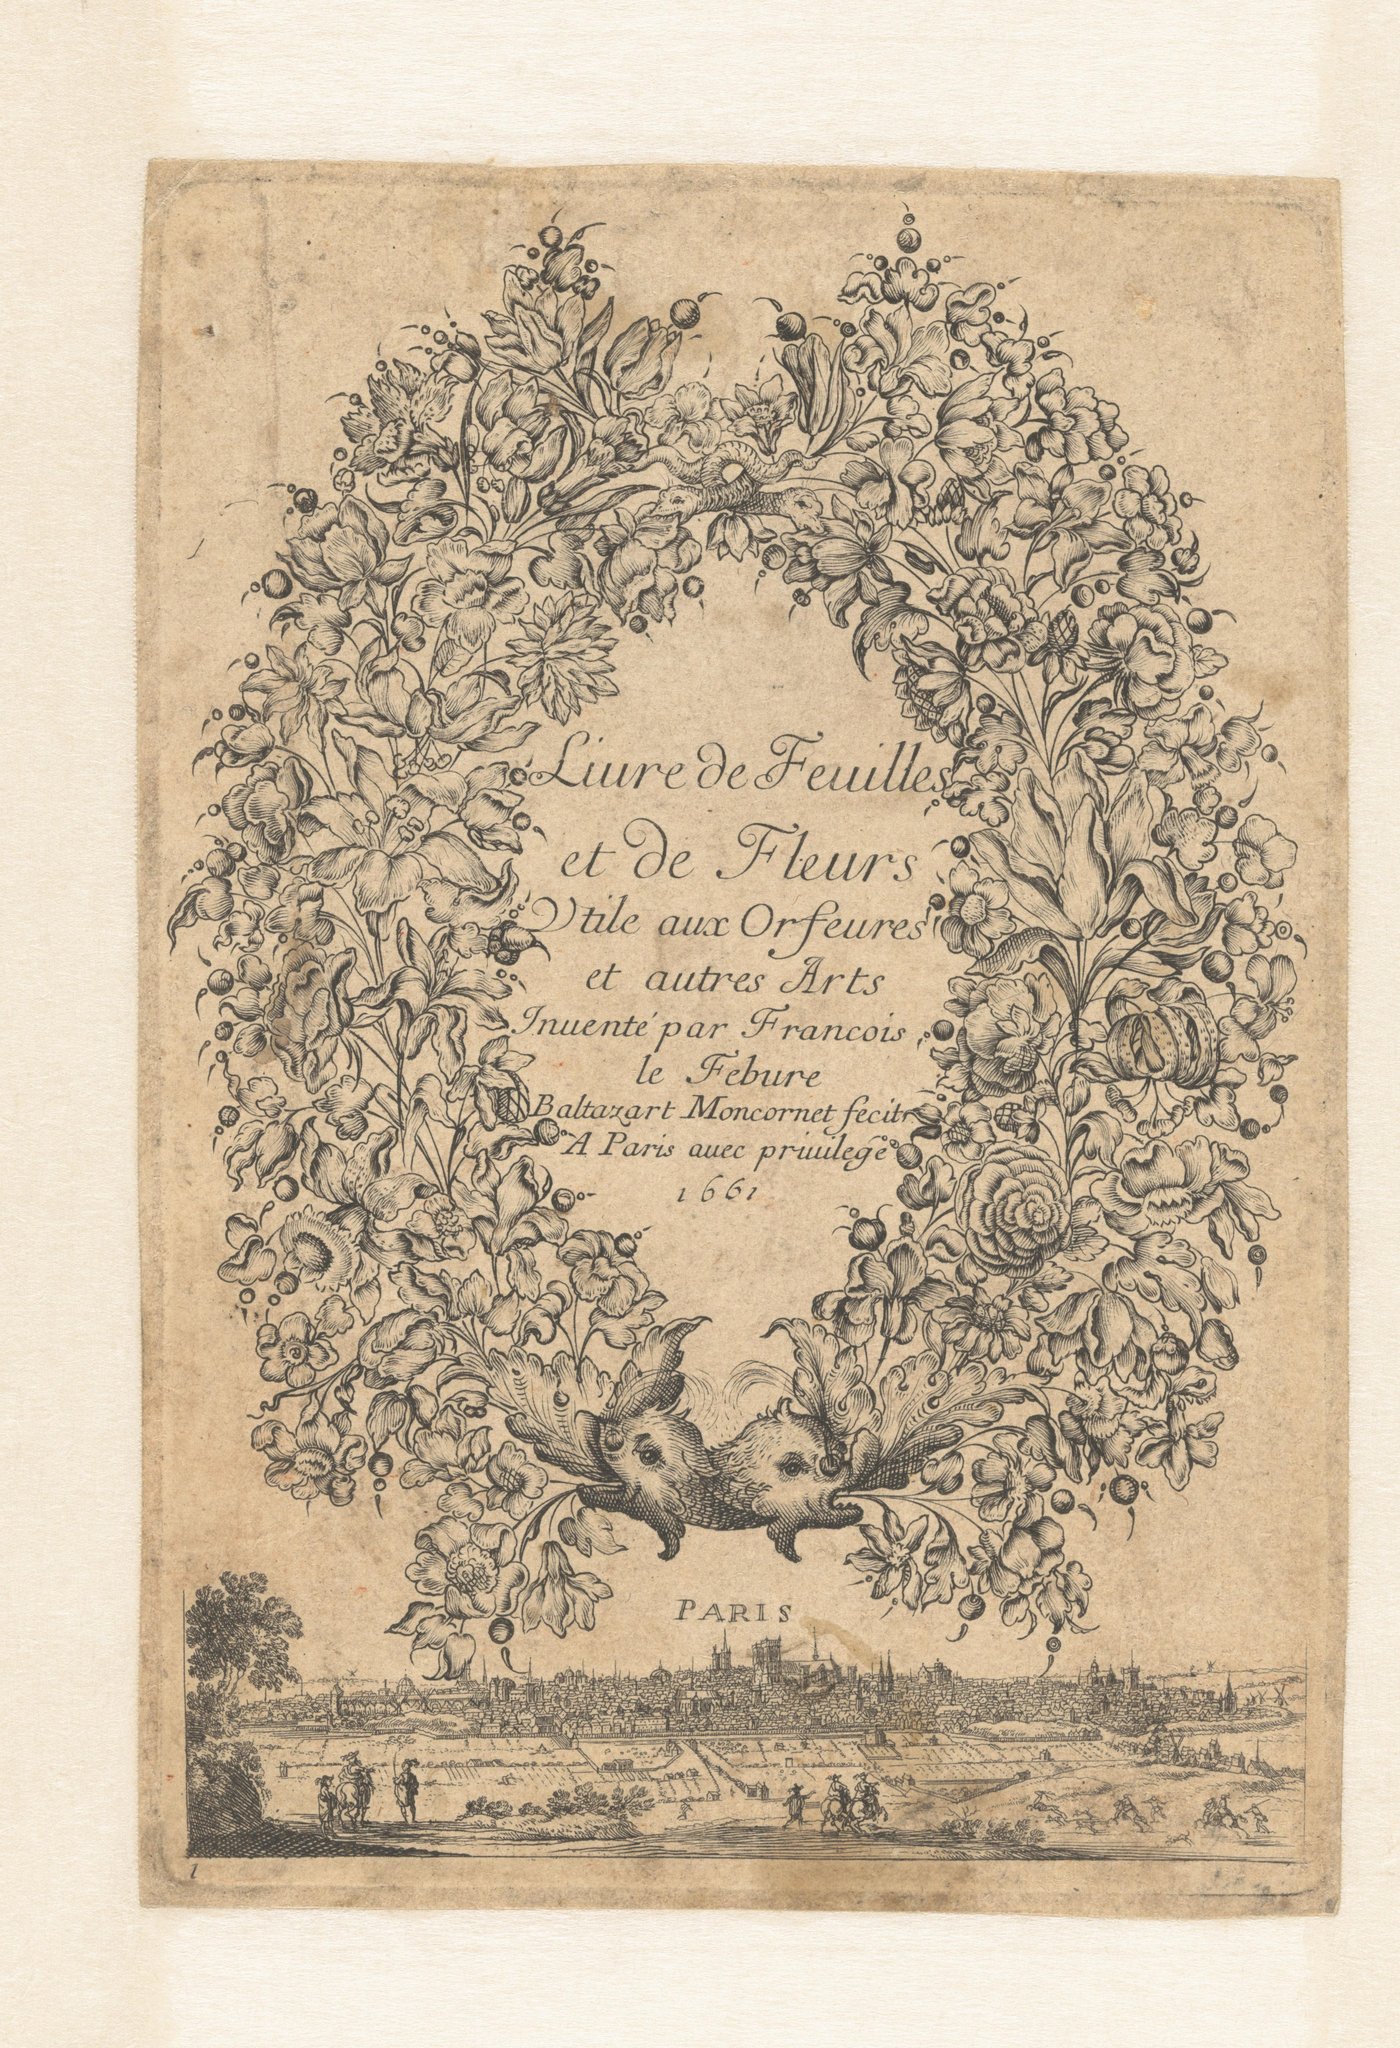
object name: titelprent, frontispice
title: Livre de Feuilles et de Fleurs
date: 1661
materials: paper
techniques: engraving, etching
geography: paris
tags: ornaments ~ art, foliage ~ ornament, city-view in general; 'veduta', ornament ~ medallion, title-page, ornament ~ festoon, garland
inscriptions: : ‘PARIS’, date: ‘1661’, privilege: ‘A Paris auec priuilege’, signature: ‘Baltazart Moncornet fecit’, collector's mark: Lugt 2228, signature: ‘Inuenté par Francois / le Febure’, number: ‘1’, collector's mark: Lugt 2760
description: Titelprent bestaande uit een ovaal medaillon van twee guirlandes van bloemen en bladeren met in het midden een tekst. Onderaan een zicht op Parijs.